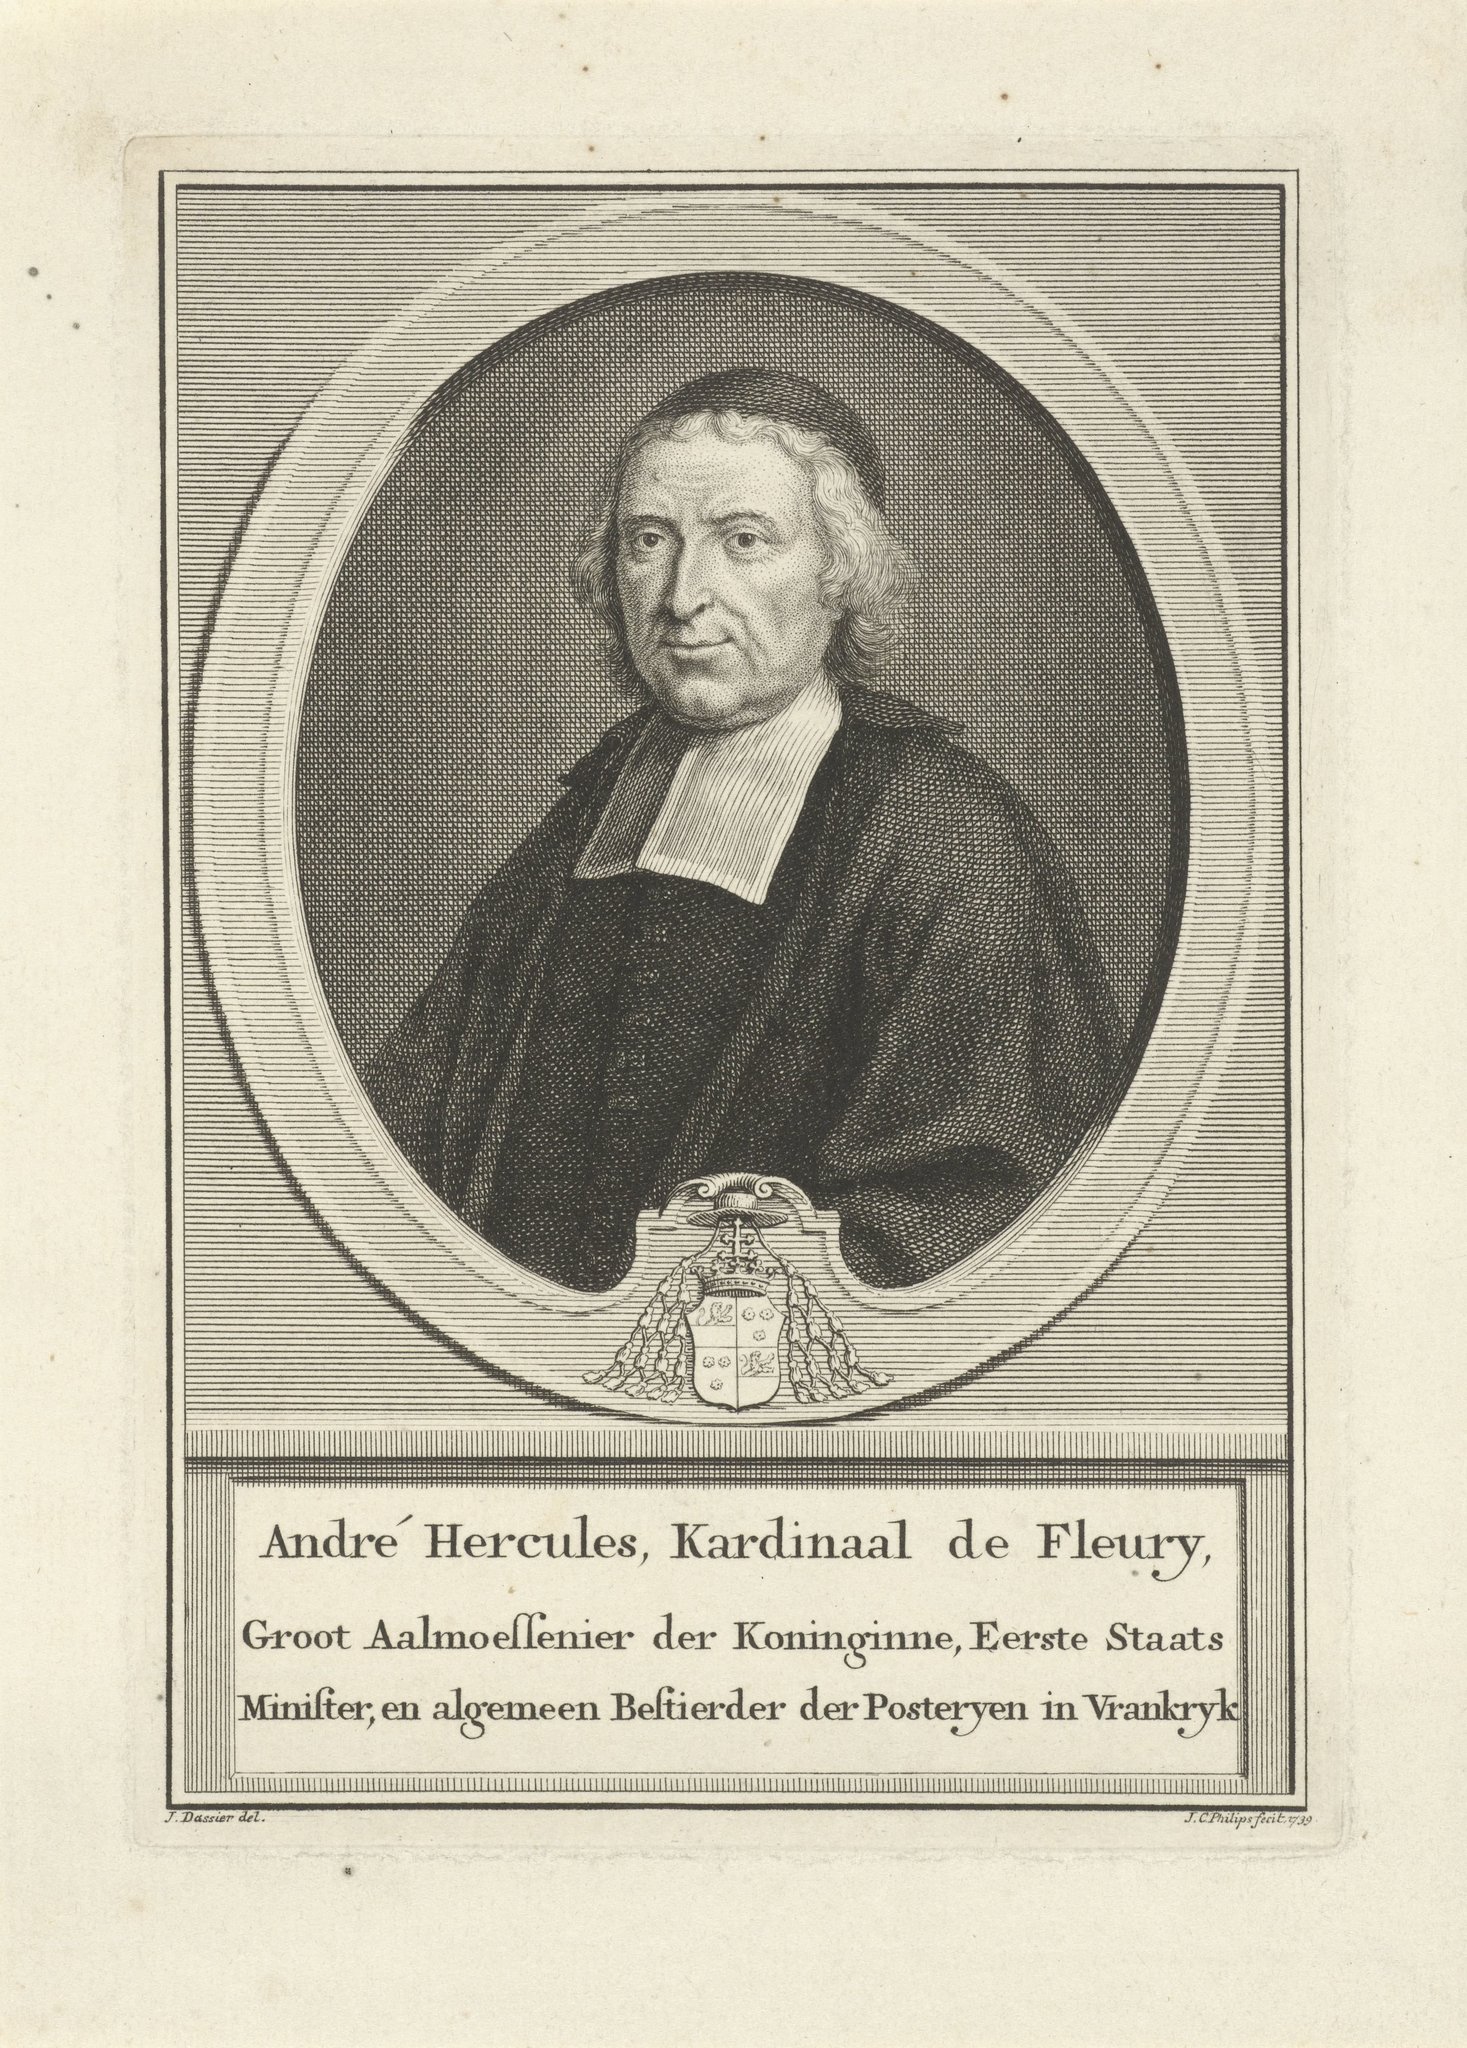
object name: print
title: Portret van de kardinaal André-Hercule de Fleury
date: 1739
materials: paper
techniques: engraving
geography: amsterdam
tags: france, insignia of cardinal, e.g. hat, mantle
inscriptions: collector's mark: Lugt 2228